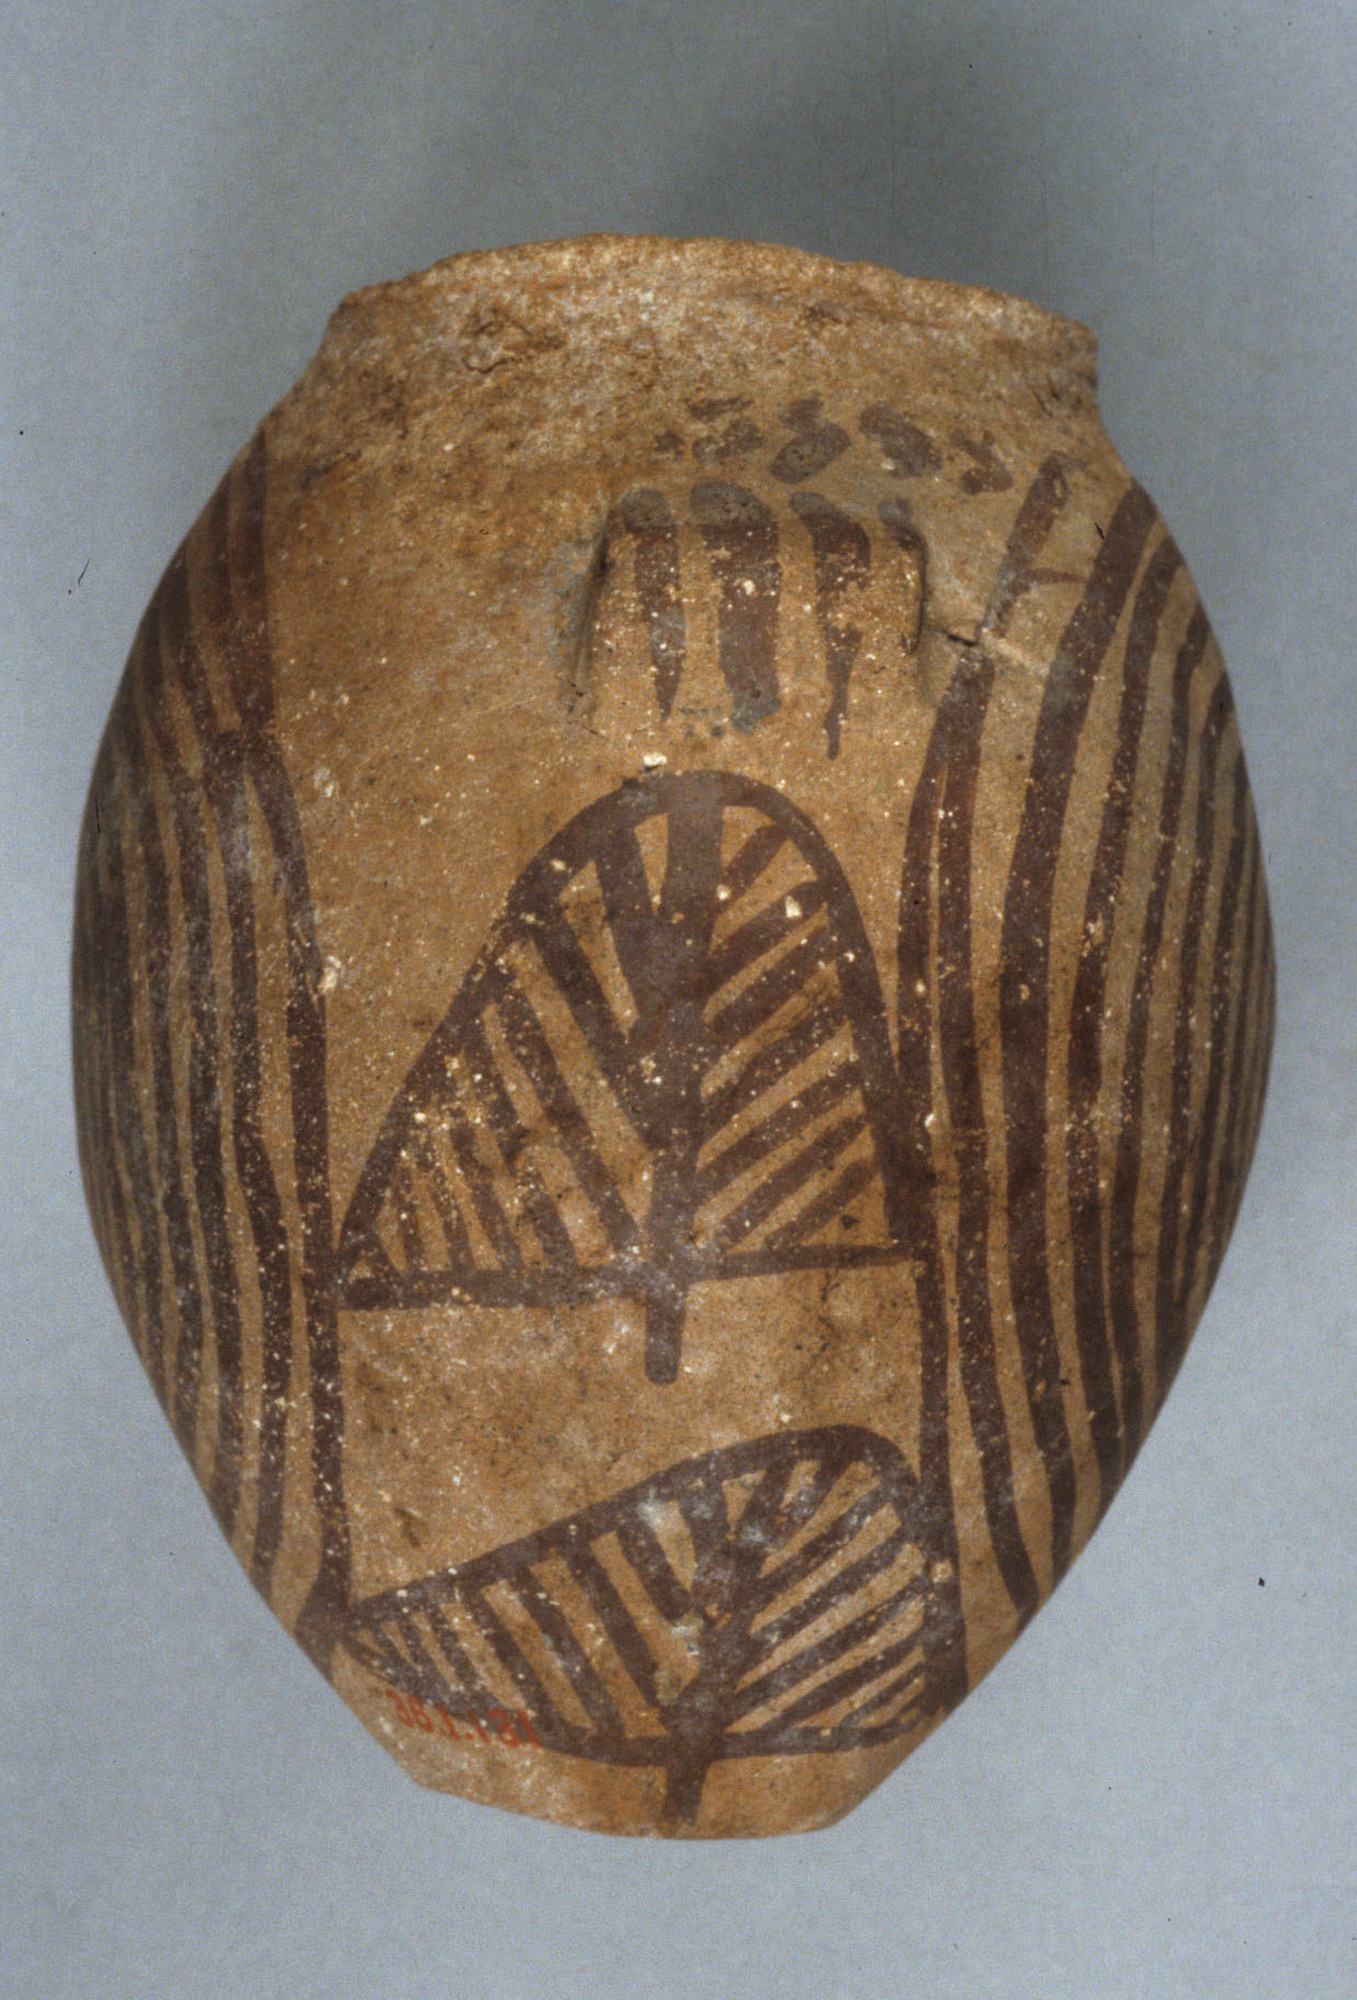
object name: jar, decorated ware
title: Decorated ware jar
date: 3500 BCE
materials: paint, pottery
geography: egypt